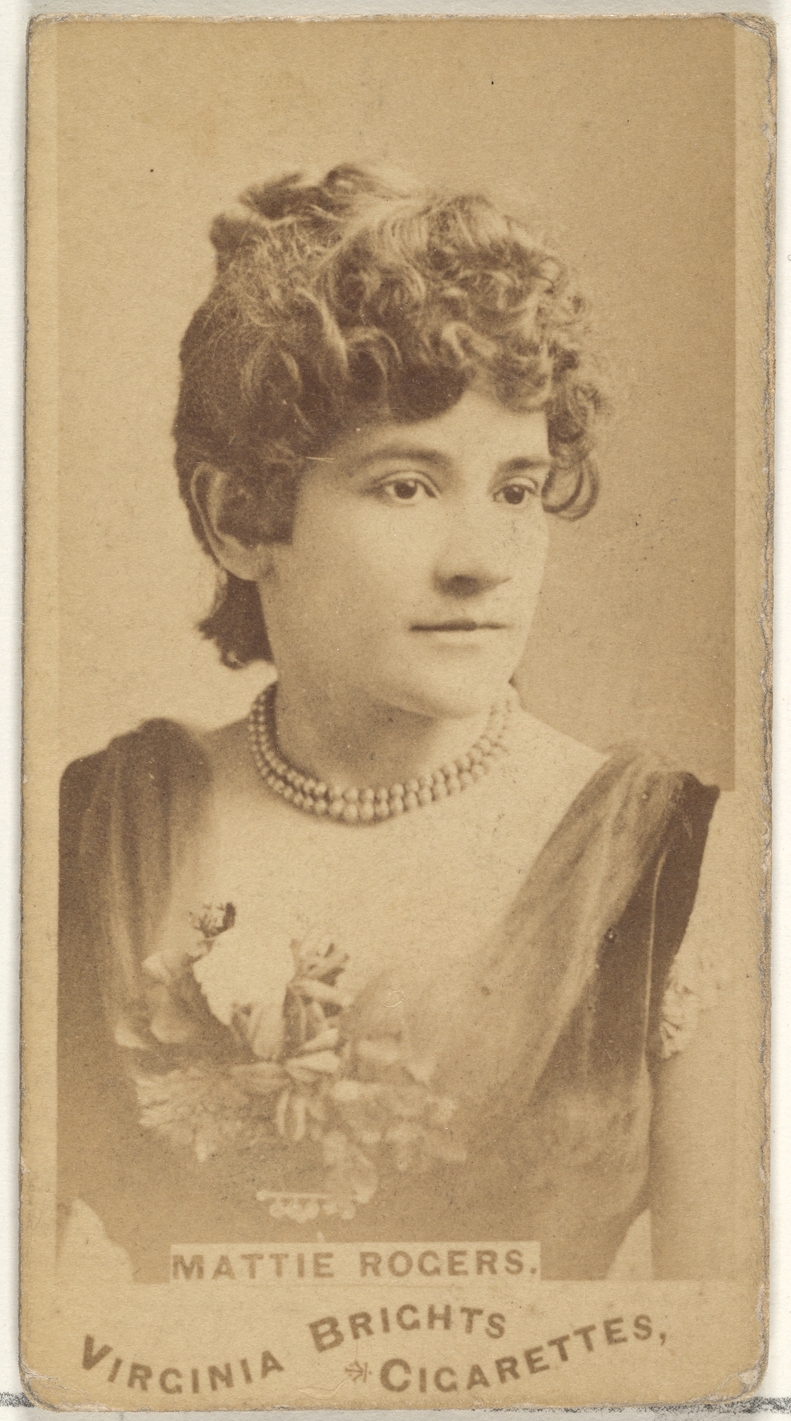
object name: photograph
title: Mattie Rogers, from the Actors and Actresses series (N45, Type 1) for Virginia Brights Cigarettes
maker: allen & ginter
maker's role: publisher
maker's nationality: american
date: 1888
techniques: albumen silver print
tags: portraits,women,actresses